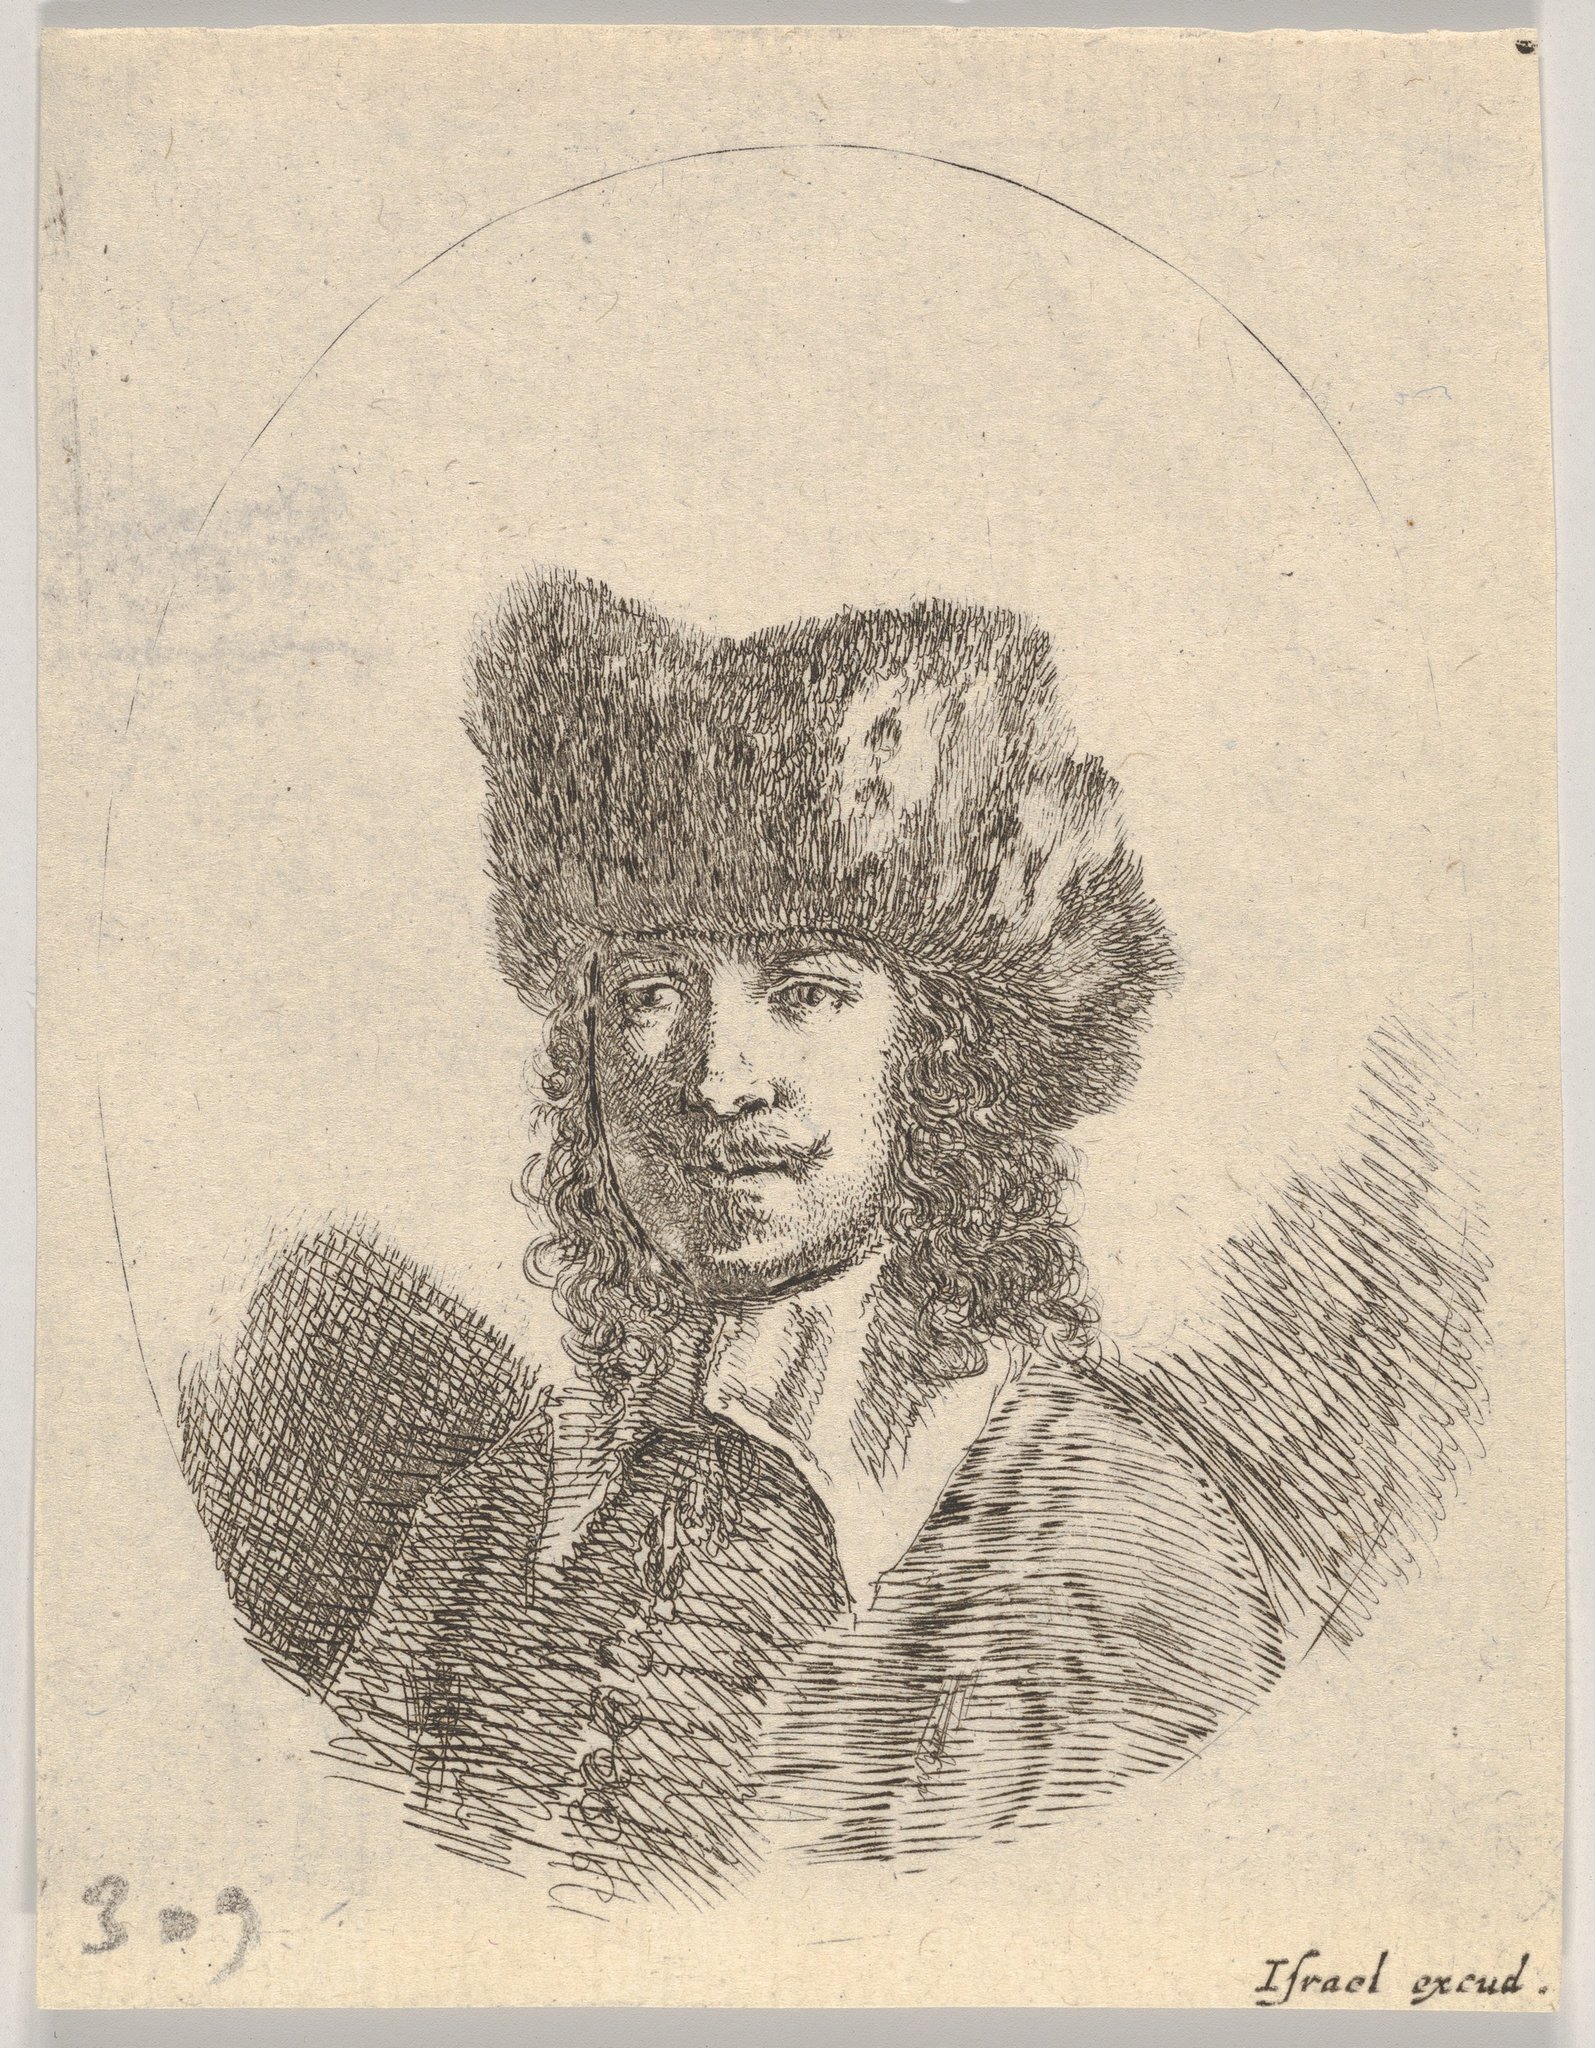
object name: print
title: Plate 2: Head of a man with a moustache and fur cap facing left, from "Various heads and figures" (Diverses têtes et figures)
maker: stefano della bella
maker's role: artist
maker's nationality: italian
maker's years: 1610-1664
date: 1650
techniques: etching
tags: men,portraits